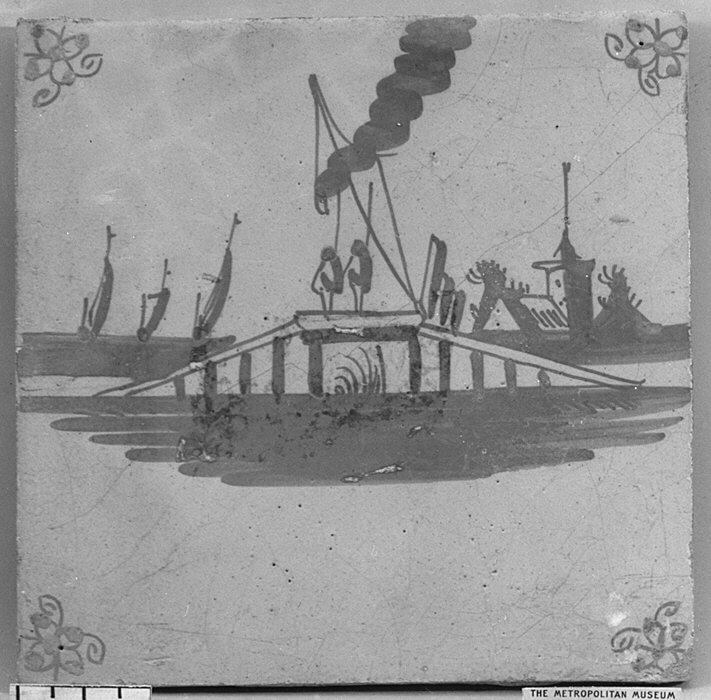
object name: tile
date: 1701-1800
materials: earthenware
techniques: glazing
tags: bridges,boats